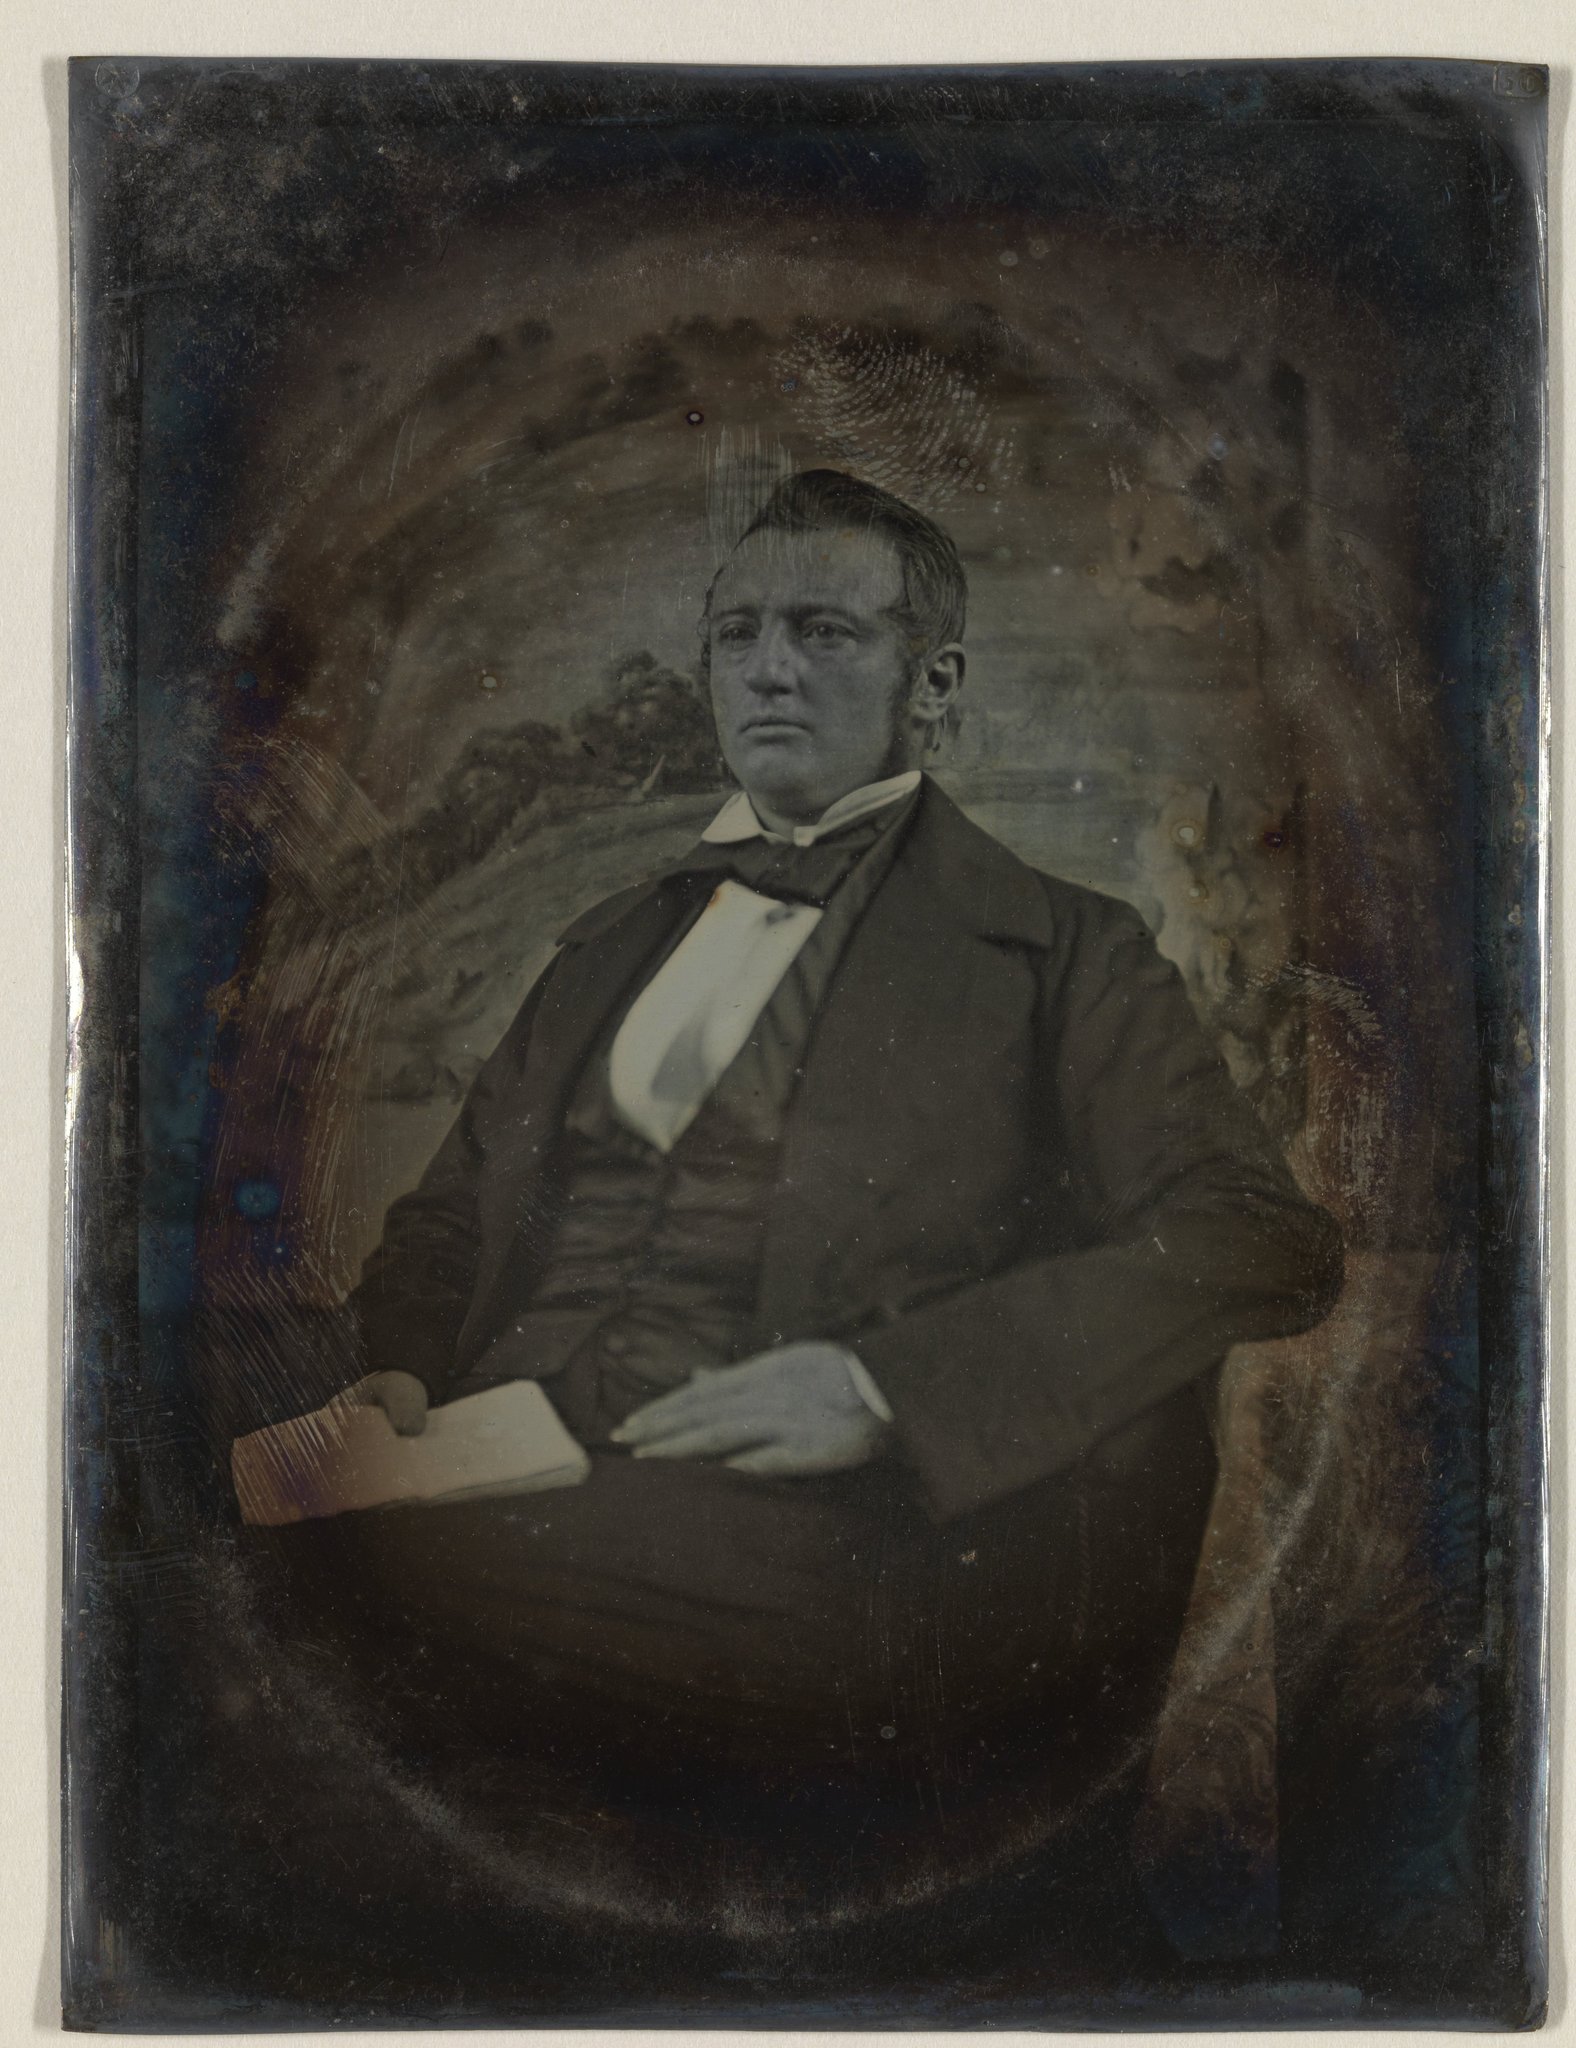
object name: photograph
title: Portret van Geldolph Adriaan de Lange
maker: Anonymous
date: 1850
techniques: daguerreotype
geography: dutch east indies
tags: the hague, dutch east indies, the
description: Datering is afgeleid van de leefjaren van de heer De Lange. G.A. de Lange is de vader van Jeannette de Lange, afgebeeld op ons Toorop-schilderij SK-A-4989 en echtgenoot van Margaretha Jacoba Wiggers van Kerchem RP-P-2010-176. [M. Boom, 2010-10-26]